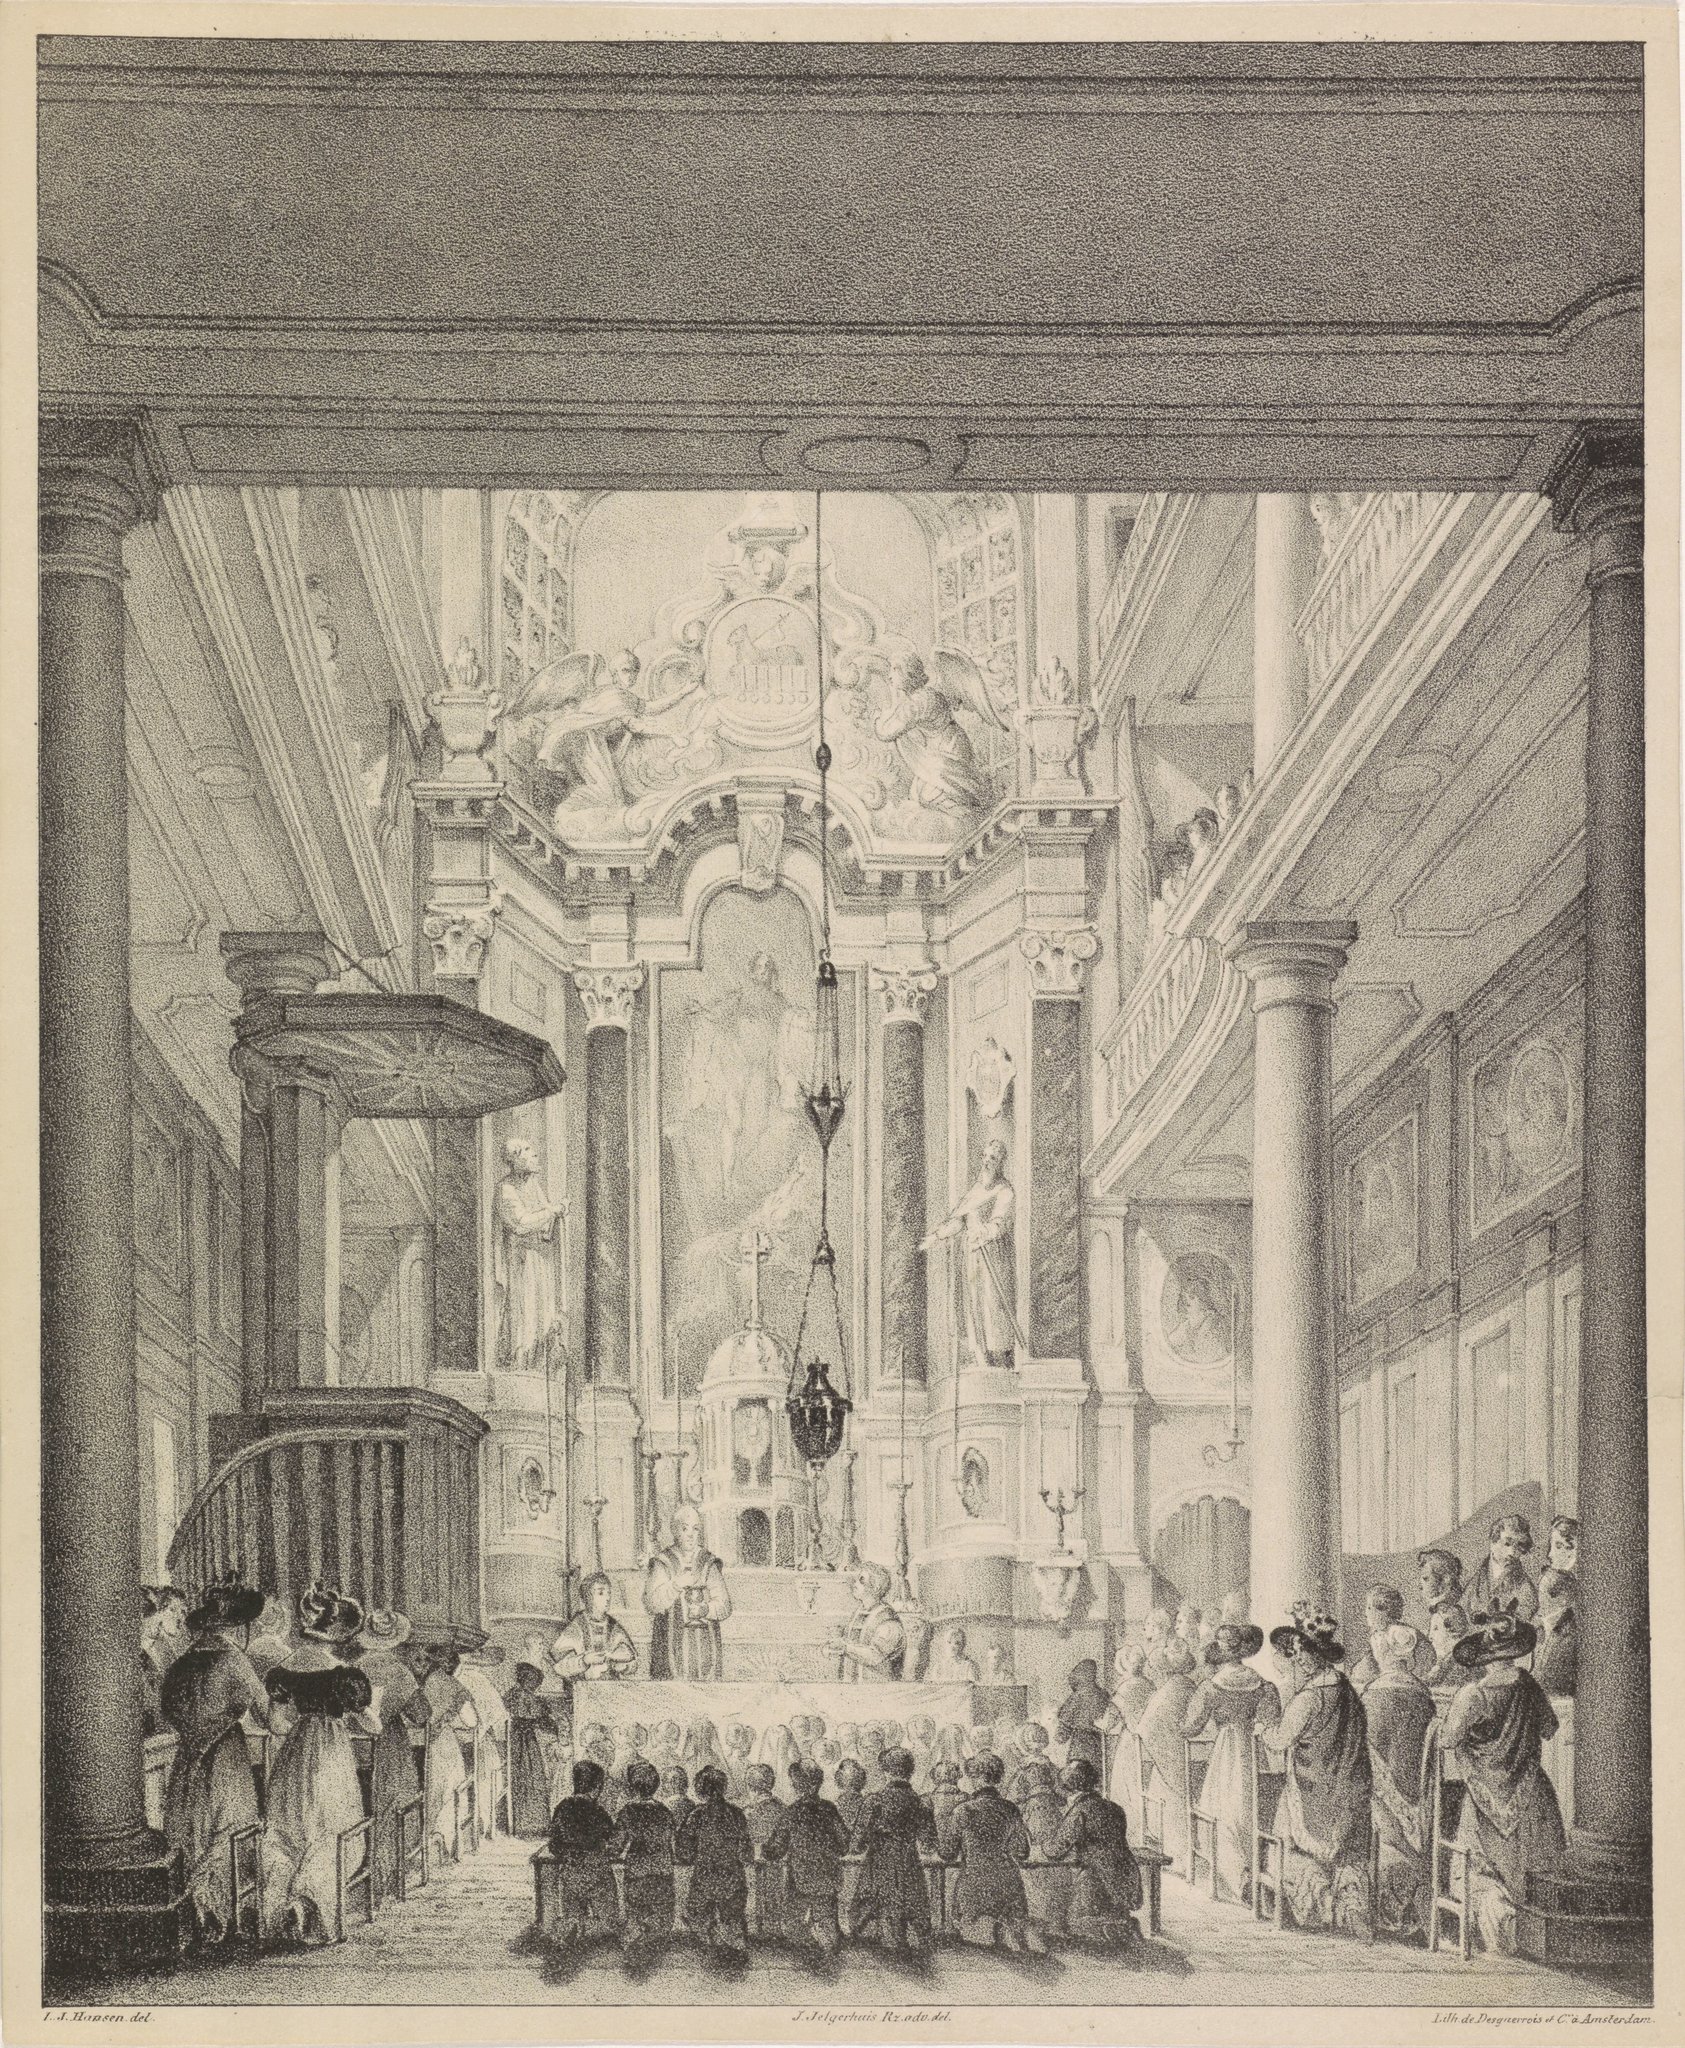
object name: print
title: Toelating van kinderen tot de eerste heilige communie in de rooms-katholiek Franse kerk op de Boommarkt te Amsterdam, ca. 1830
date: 1830-1835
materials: paper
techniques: lithograph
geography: amsterdam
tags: first communion, interior of church, communion ~ holy mass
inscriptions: collector's mark: Lugt 2228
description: Kerkinterieur waarin kinderen worden toegelaten tot de eerste heilige communie in de rooms-katholiek Franse kerk op de Boommarkt, de huidige Nieuwezijds Voorburgwal, te Amsterdam, ca. 1830-1835.